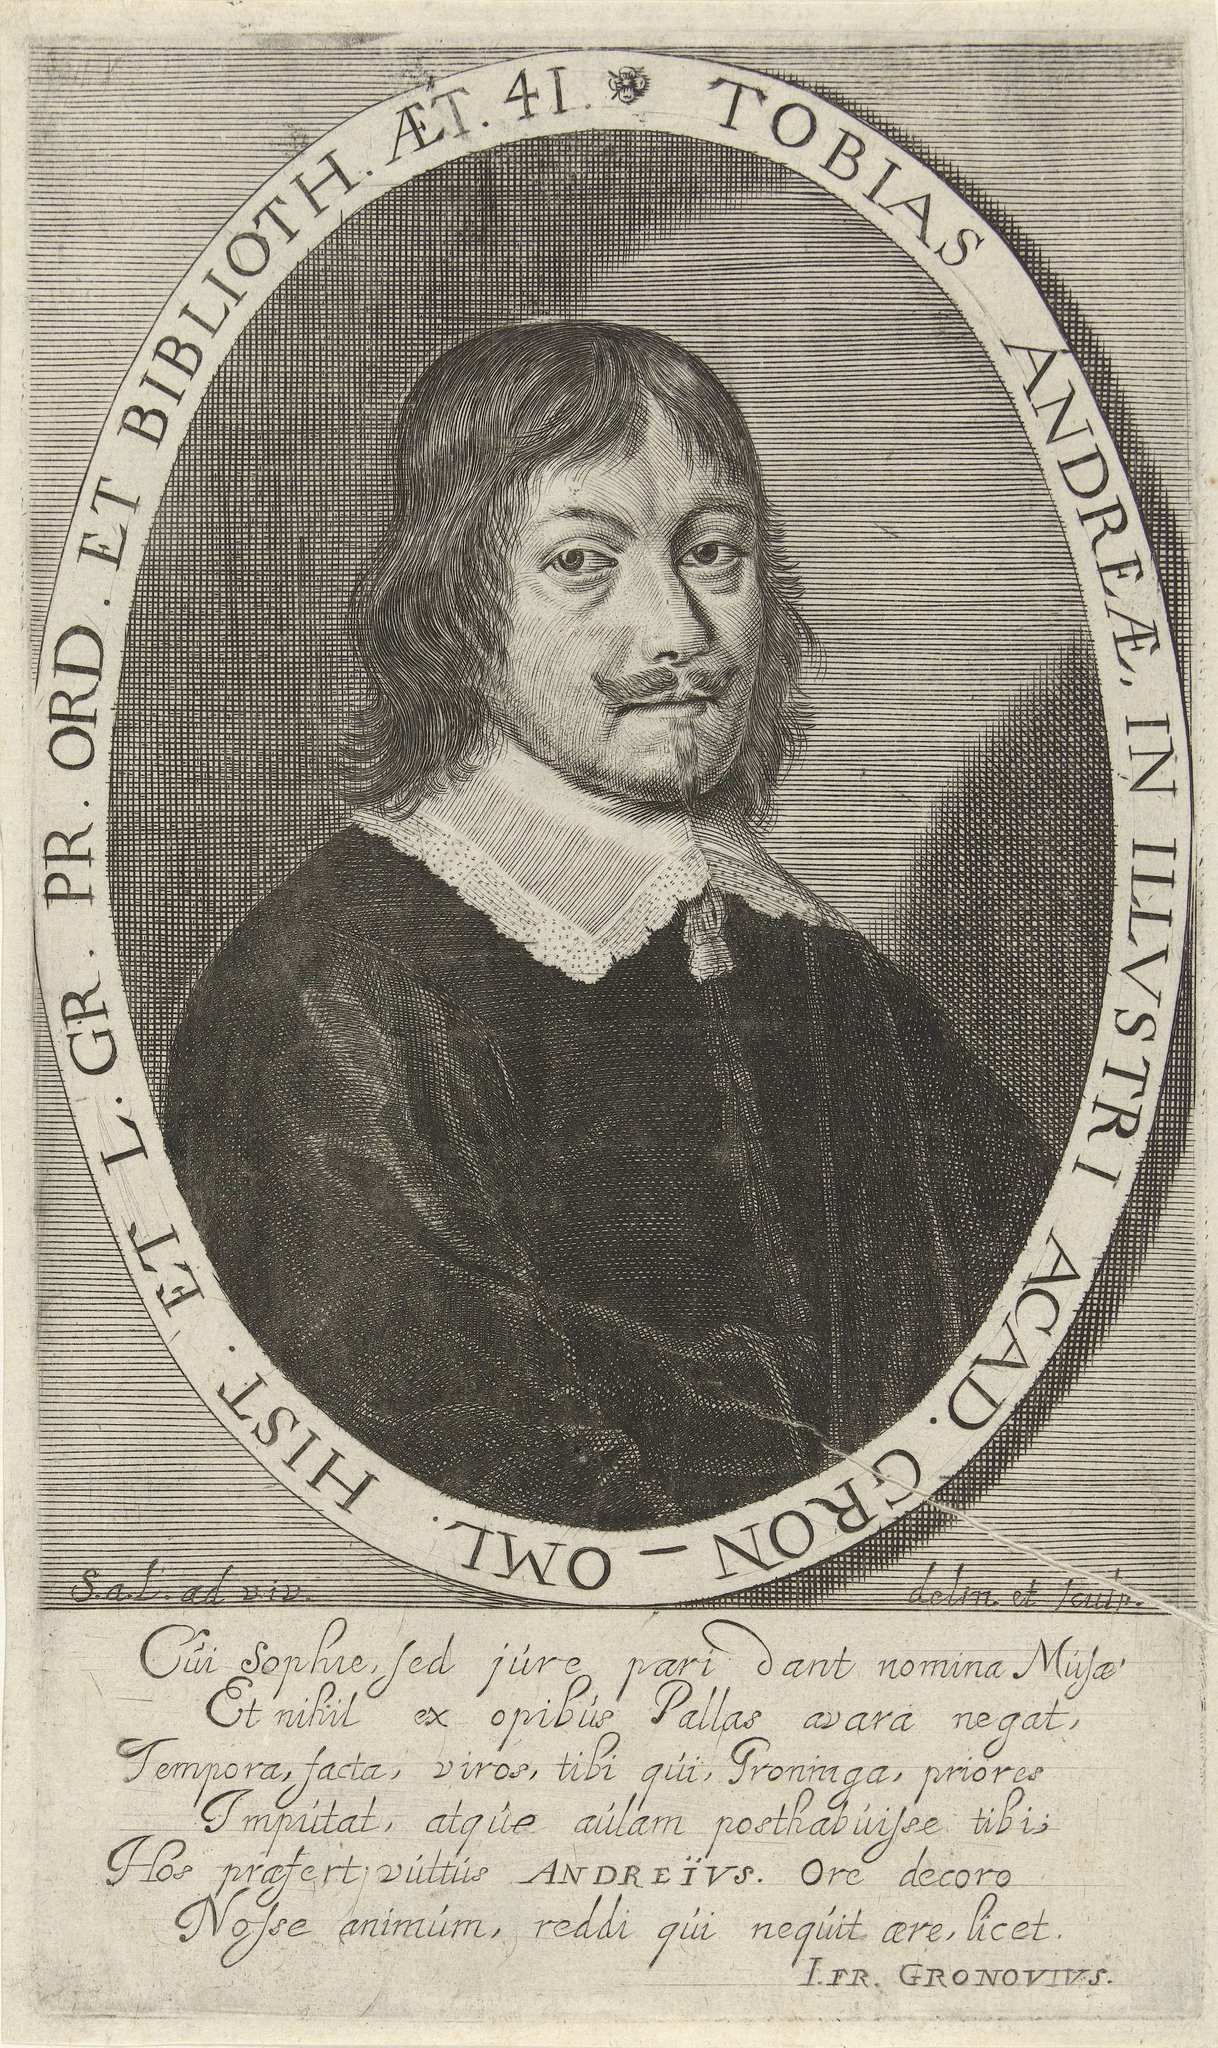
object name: print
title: Portret van Tobias Andreae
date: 1654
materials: paper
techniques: engraving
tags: tobias andreae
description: Portretbuste in ovaal naar rechts van Tobias Andreae, hoogleraar in de geschiedenis te Groningen, blootshoofds. Op de ovale omlijsting staat een randschrift in Latijn, in de marge een zesregelig Latijns vers.